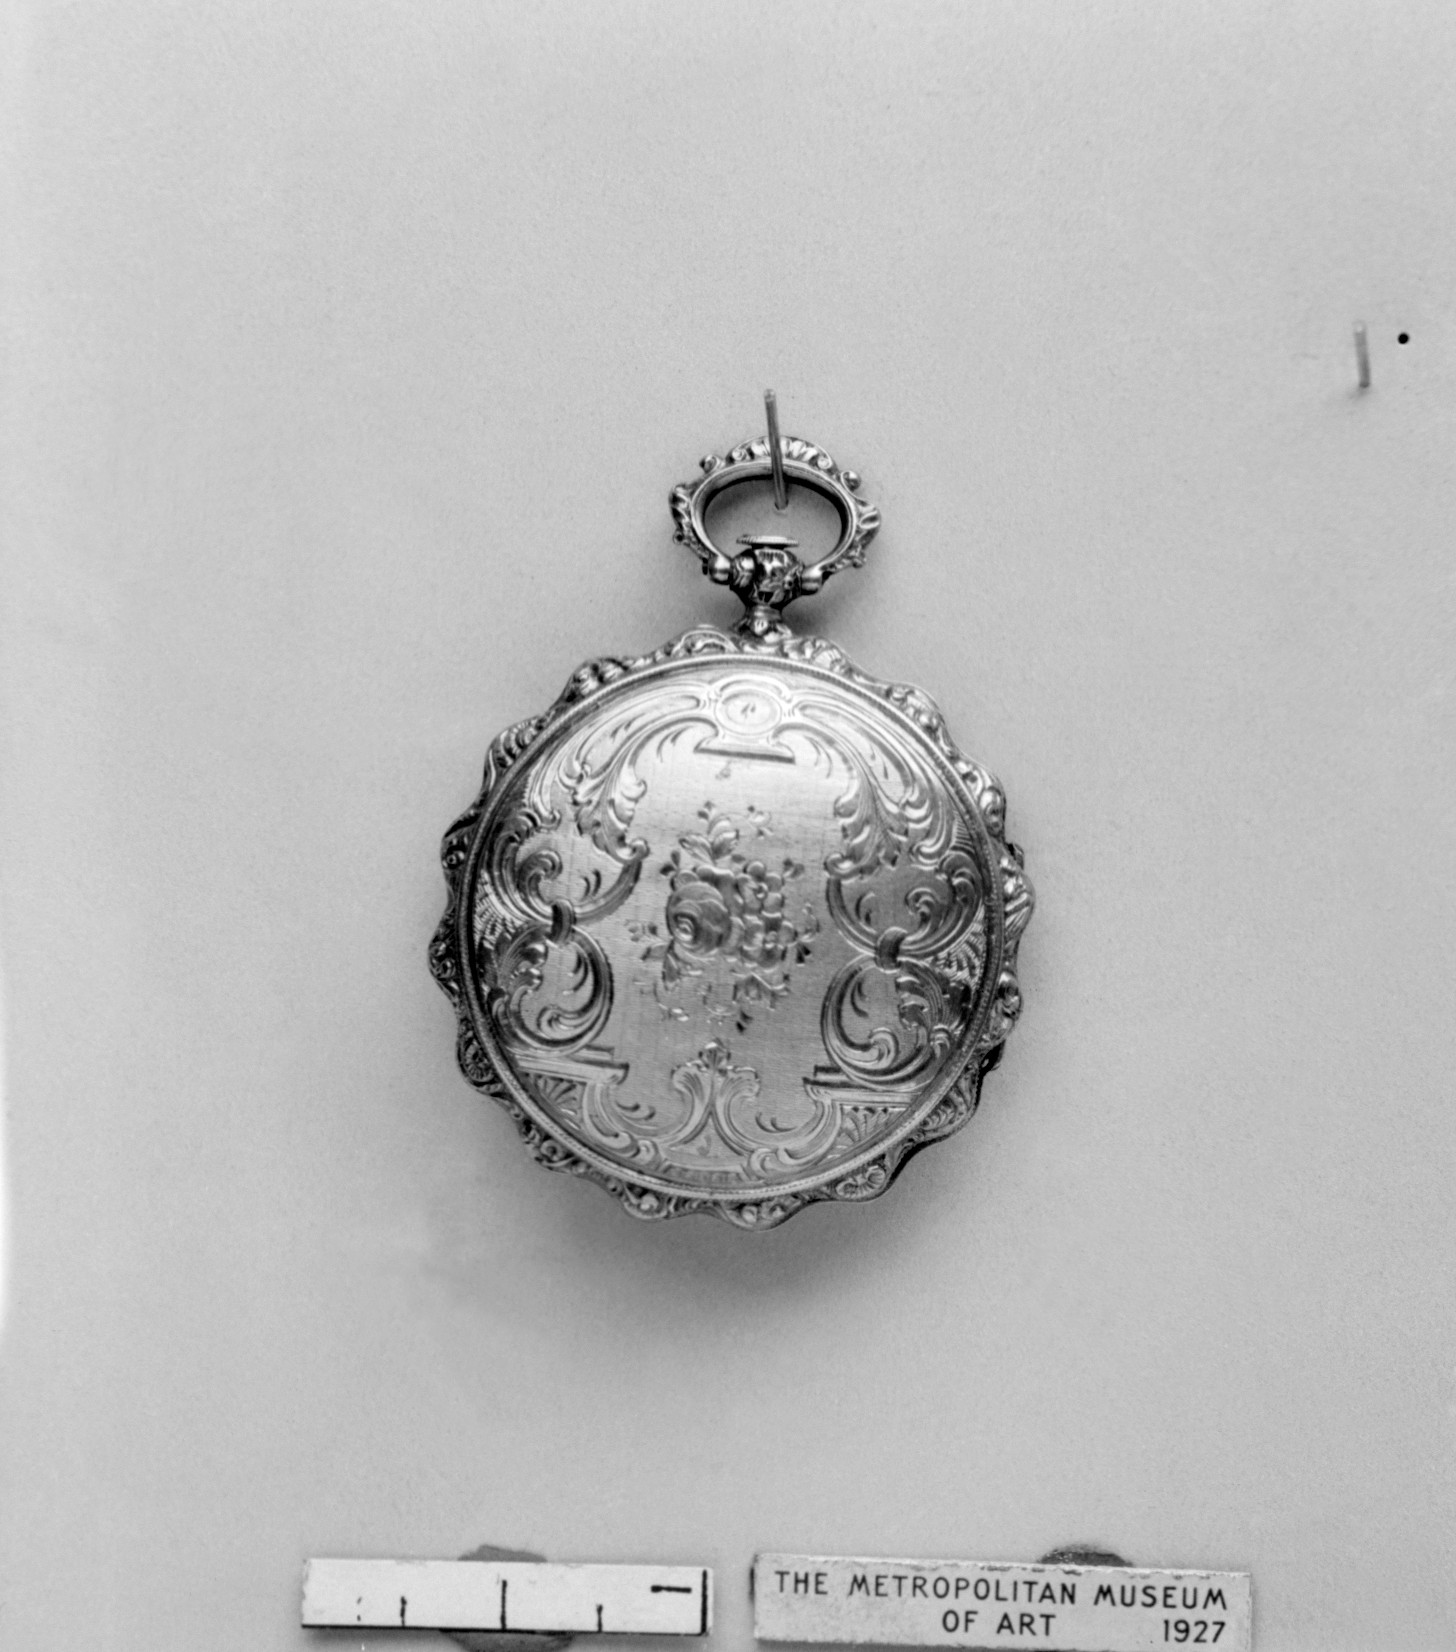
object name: watch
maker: firm of rey frères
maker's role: maker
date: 1830-1840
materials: enamel, gold, steel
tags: flowers,leaves